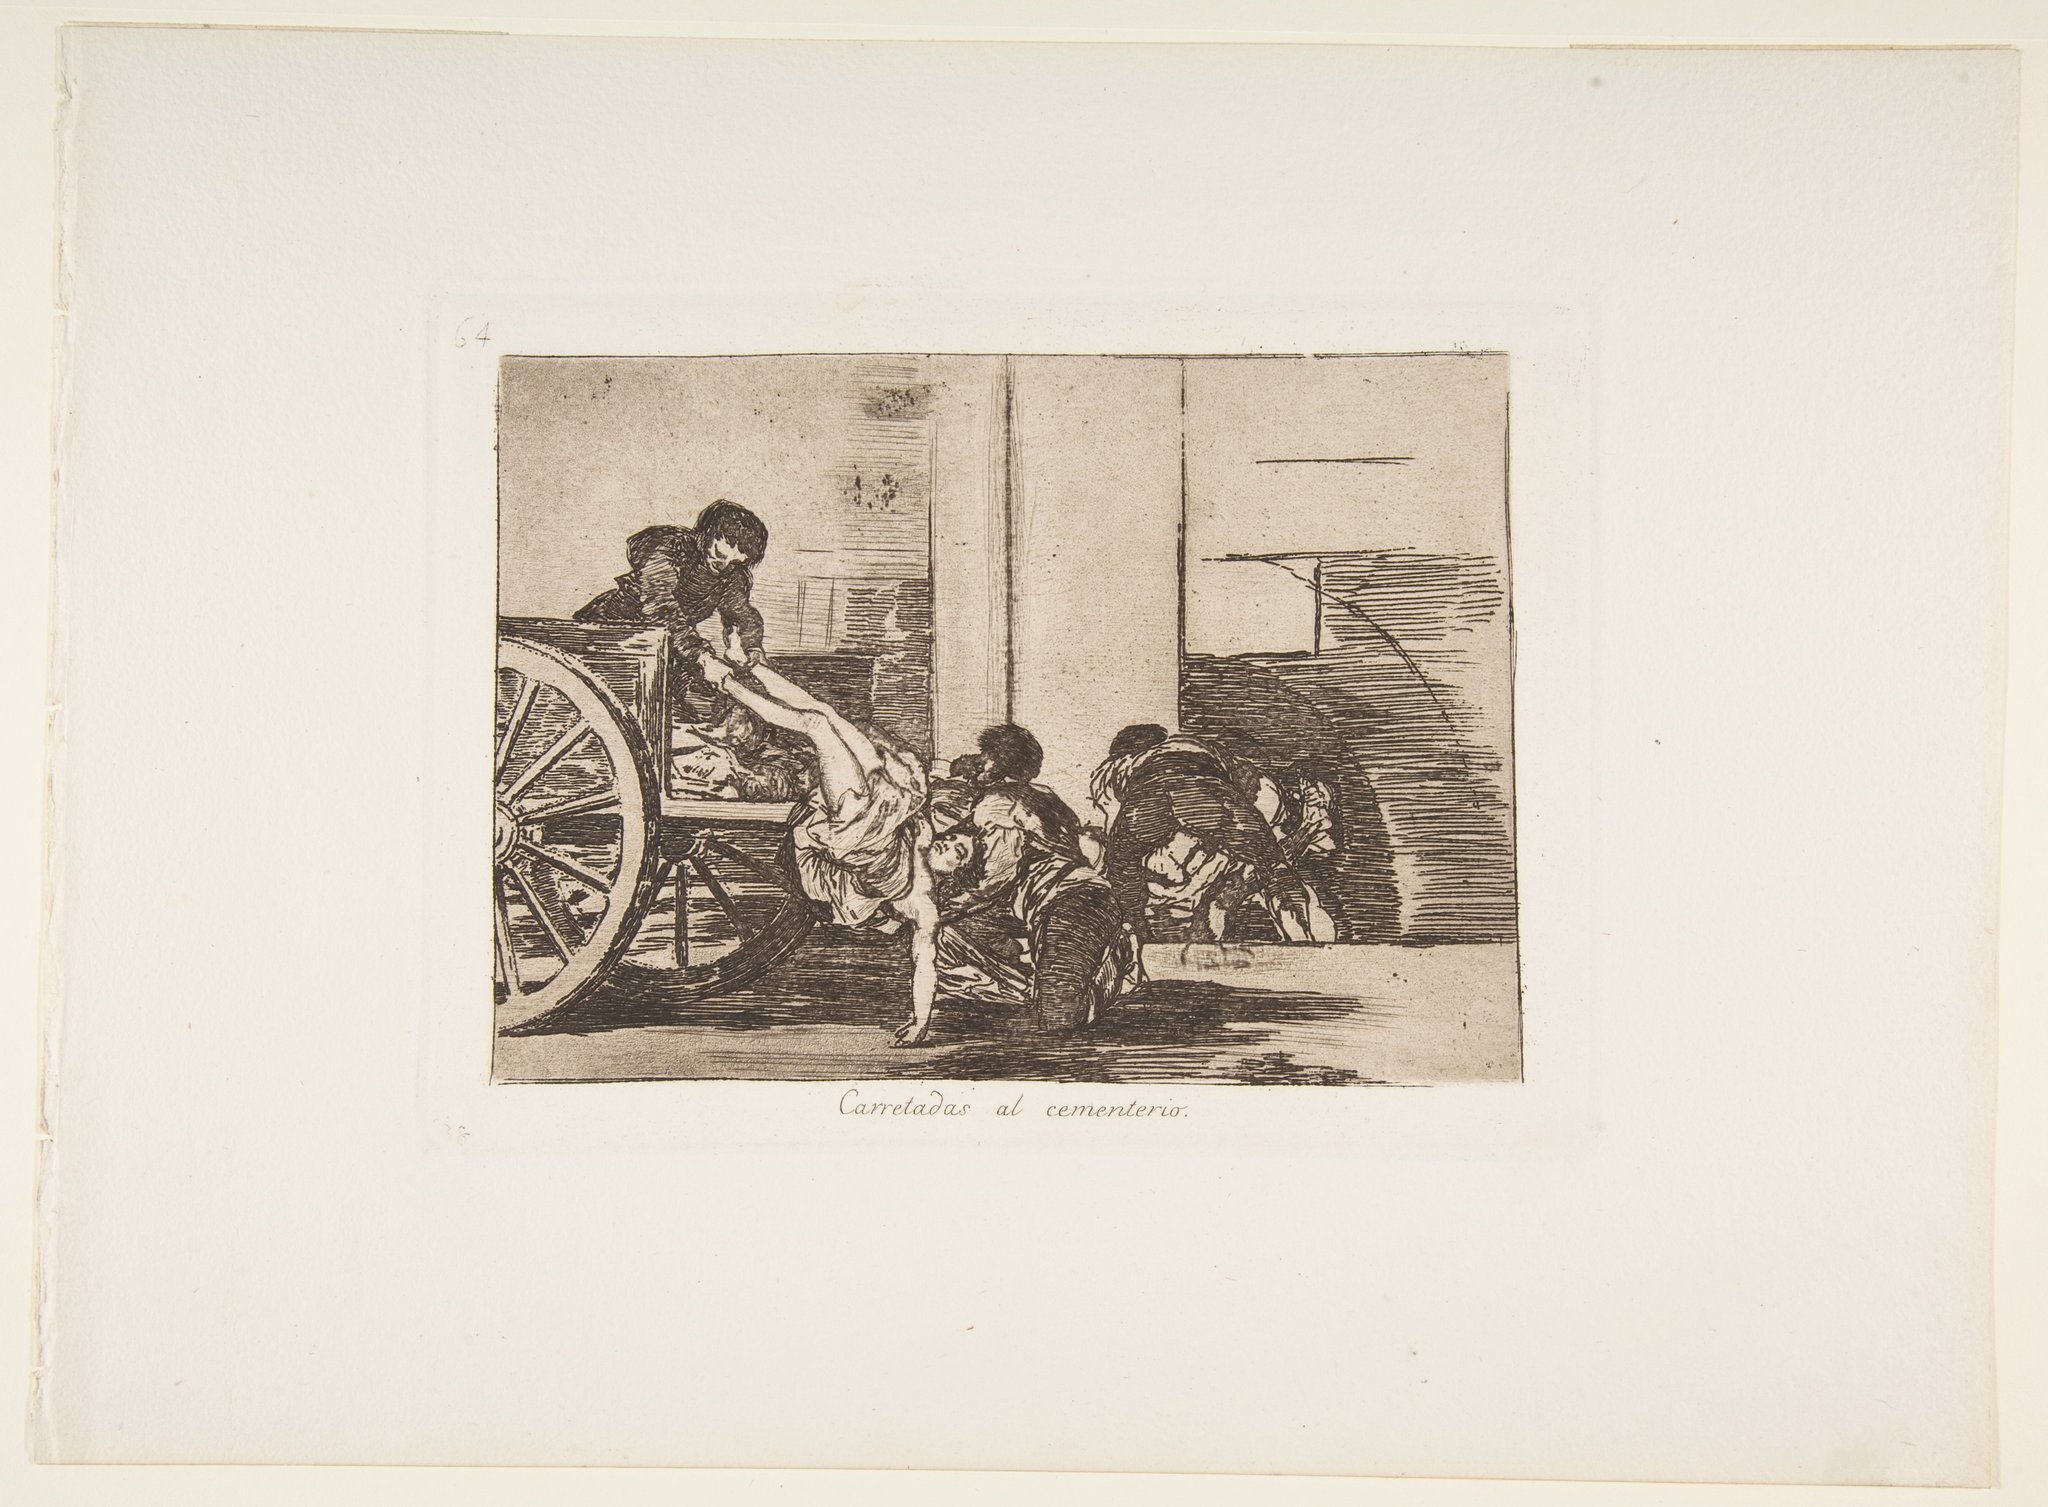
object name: print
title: Plate 64 from "The Disasters of War" (Los Desastres de la Guerra): 'Cartloads to the cemetery' (Carretadas al cementerio)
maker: goya (francisco de goya y lucientes)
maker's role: artist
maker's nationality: spanish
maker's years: 1746-1828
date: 1811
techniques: aquatint, burnishing, drypoint, etching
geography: spain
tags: men,women,death,carriages